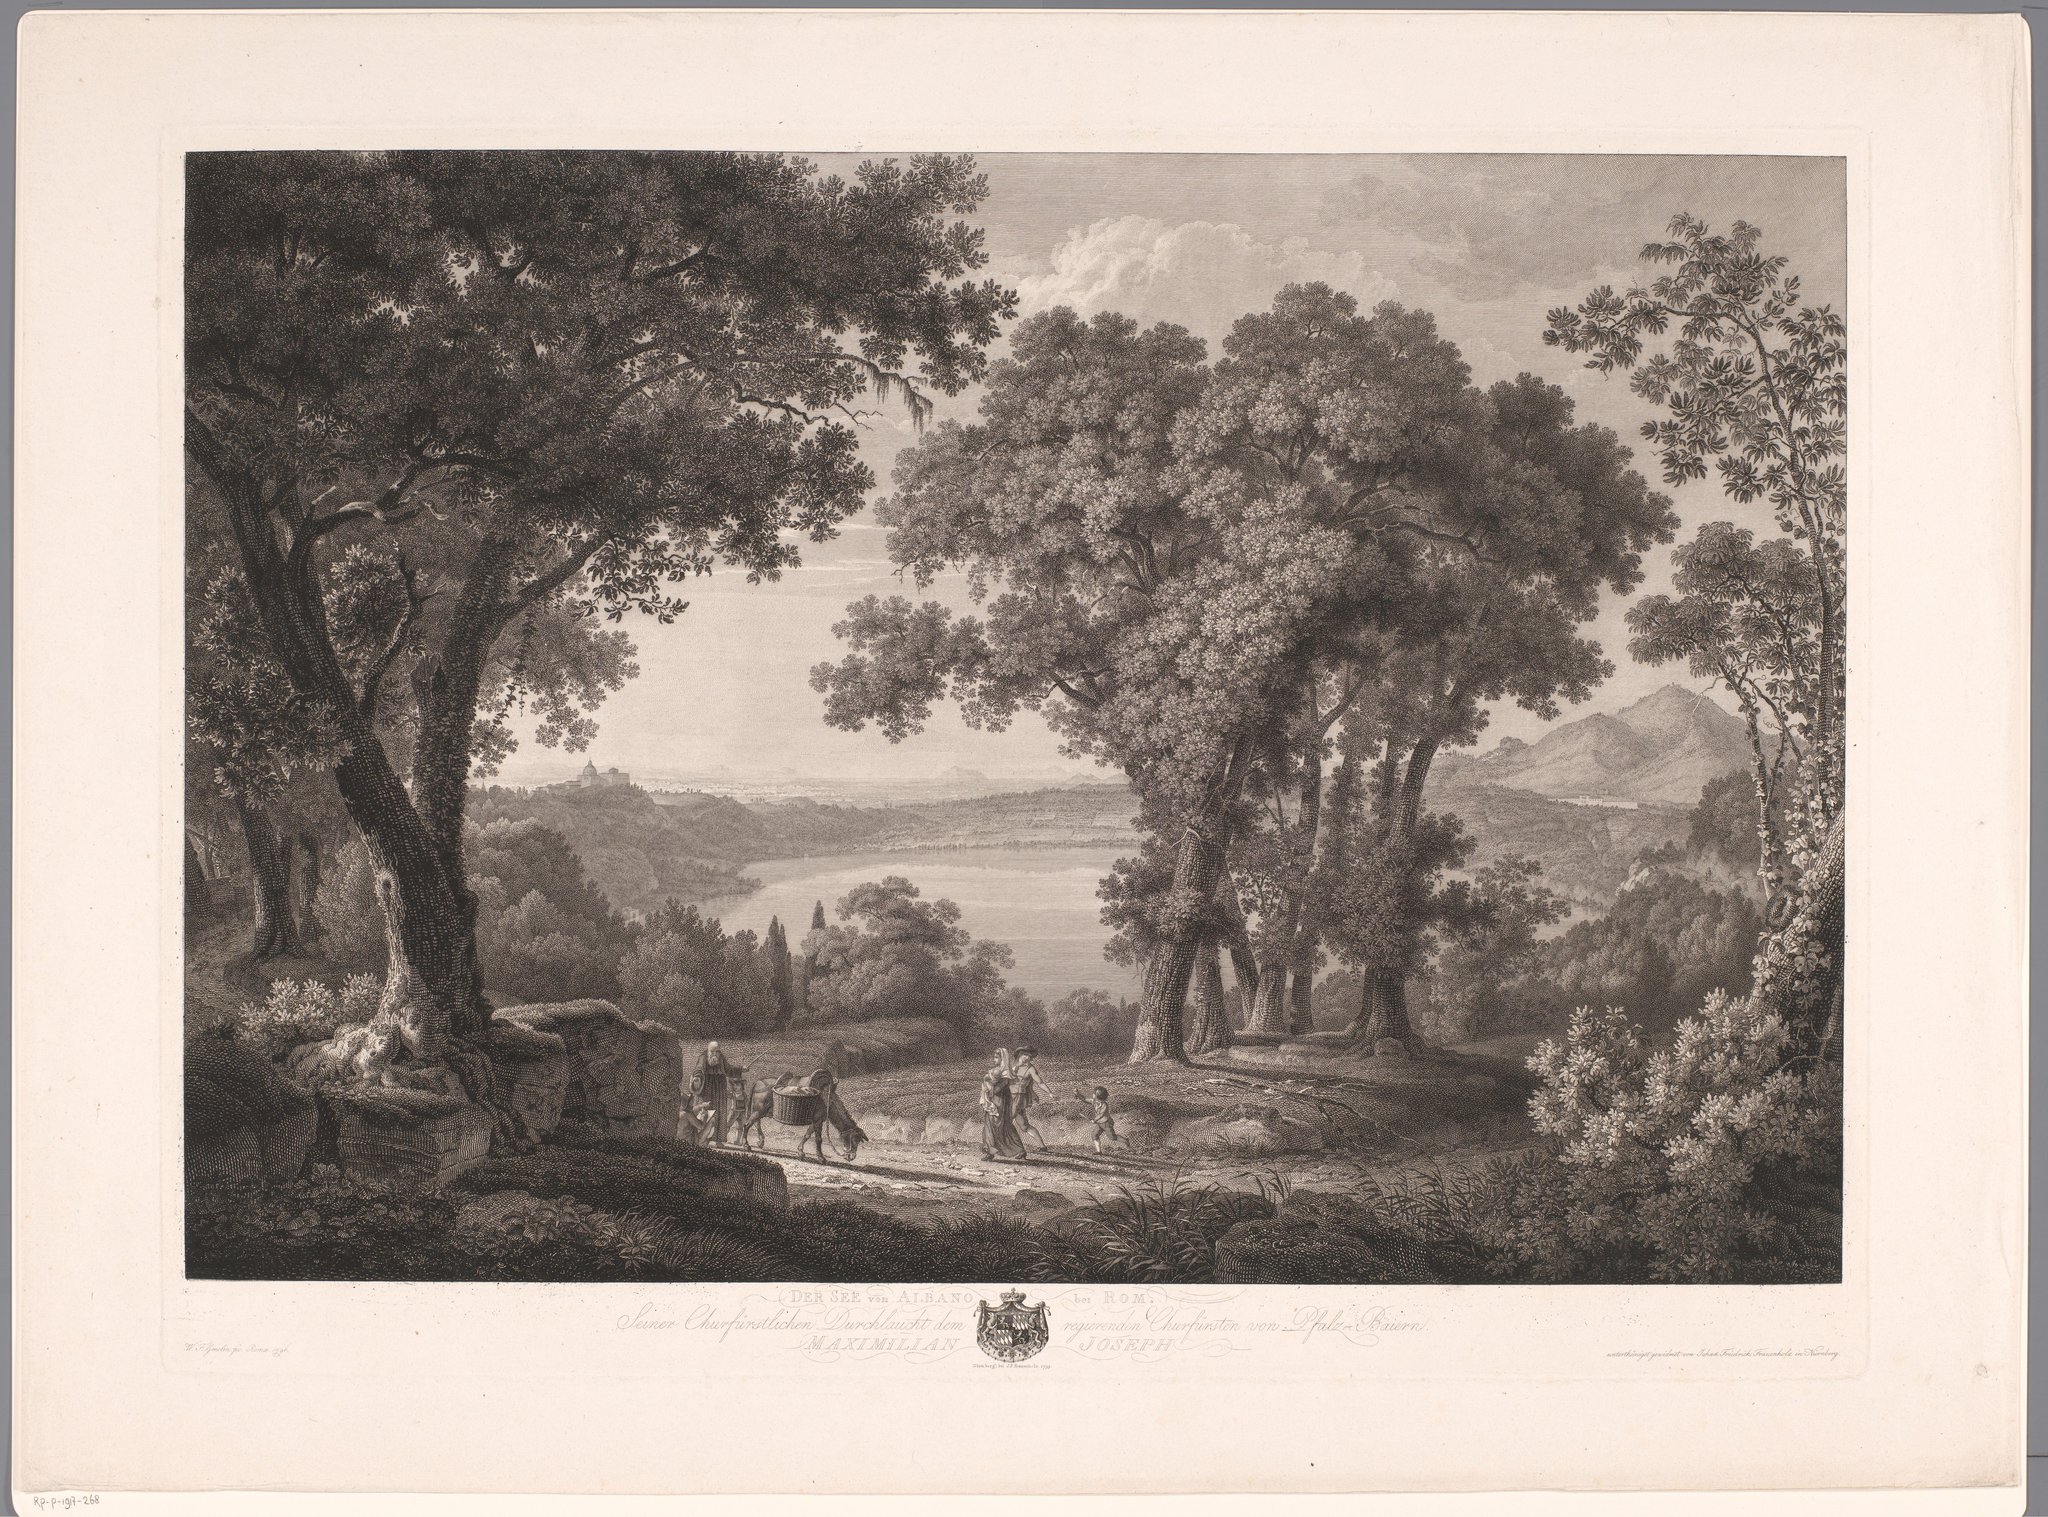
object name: print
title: Der See von Albano dei Rom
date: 1796-1799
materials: paper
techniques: etching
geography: rome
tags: landscapes, lake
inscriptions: company name: Lugt 994, collector's mark: Lugt 2228